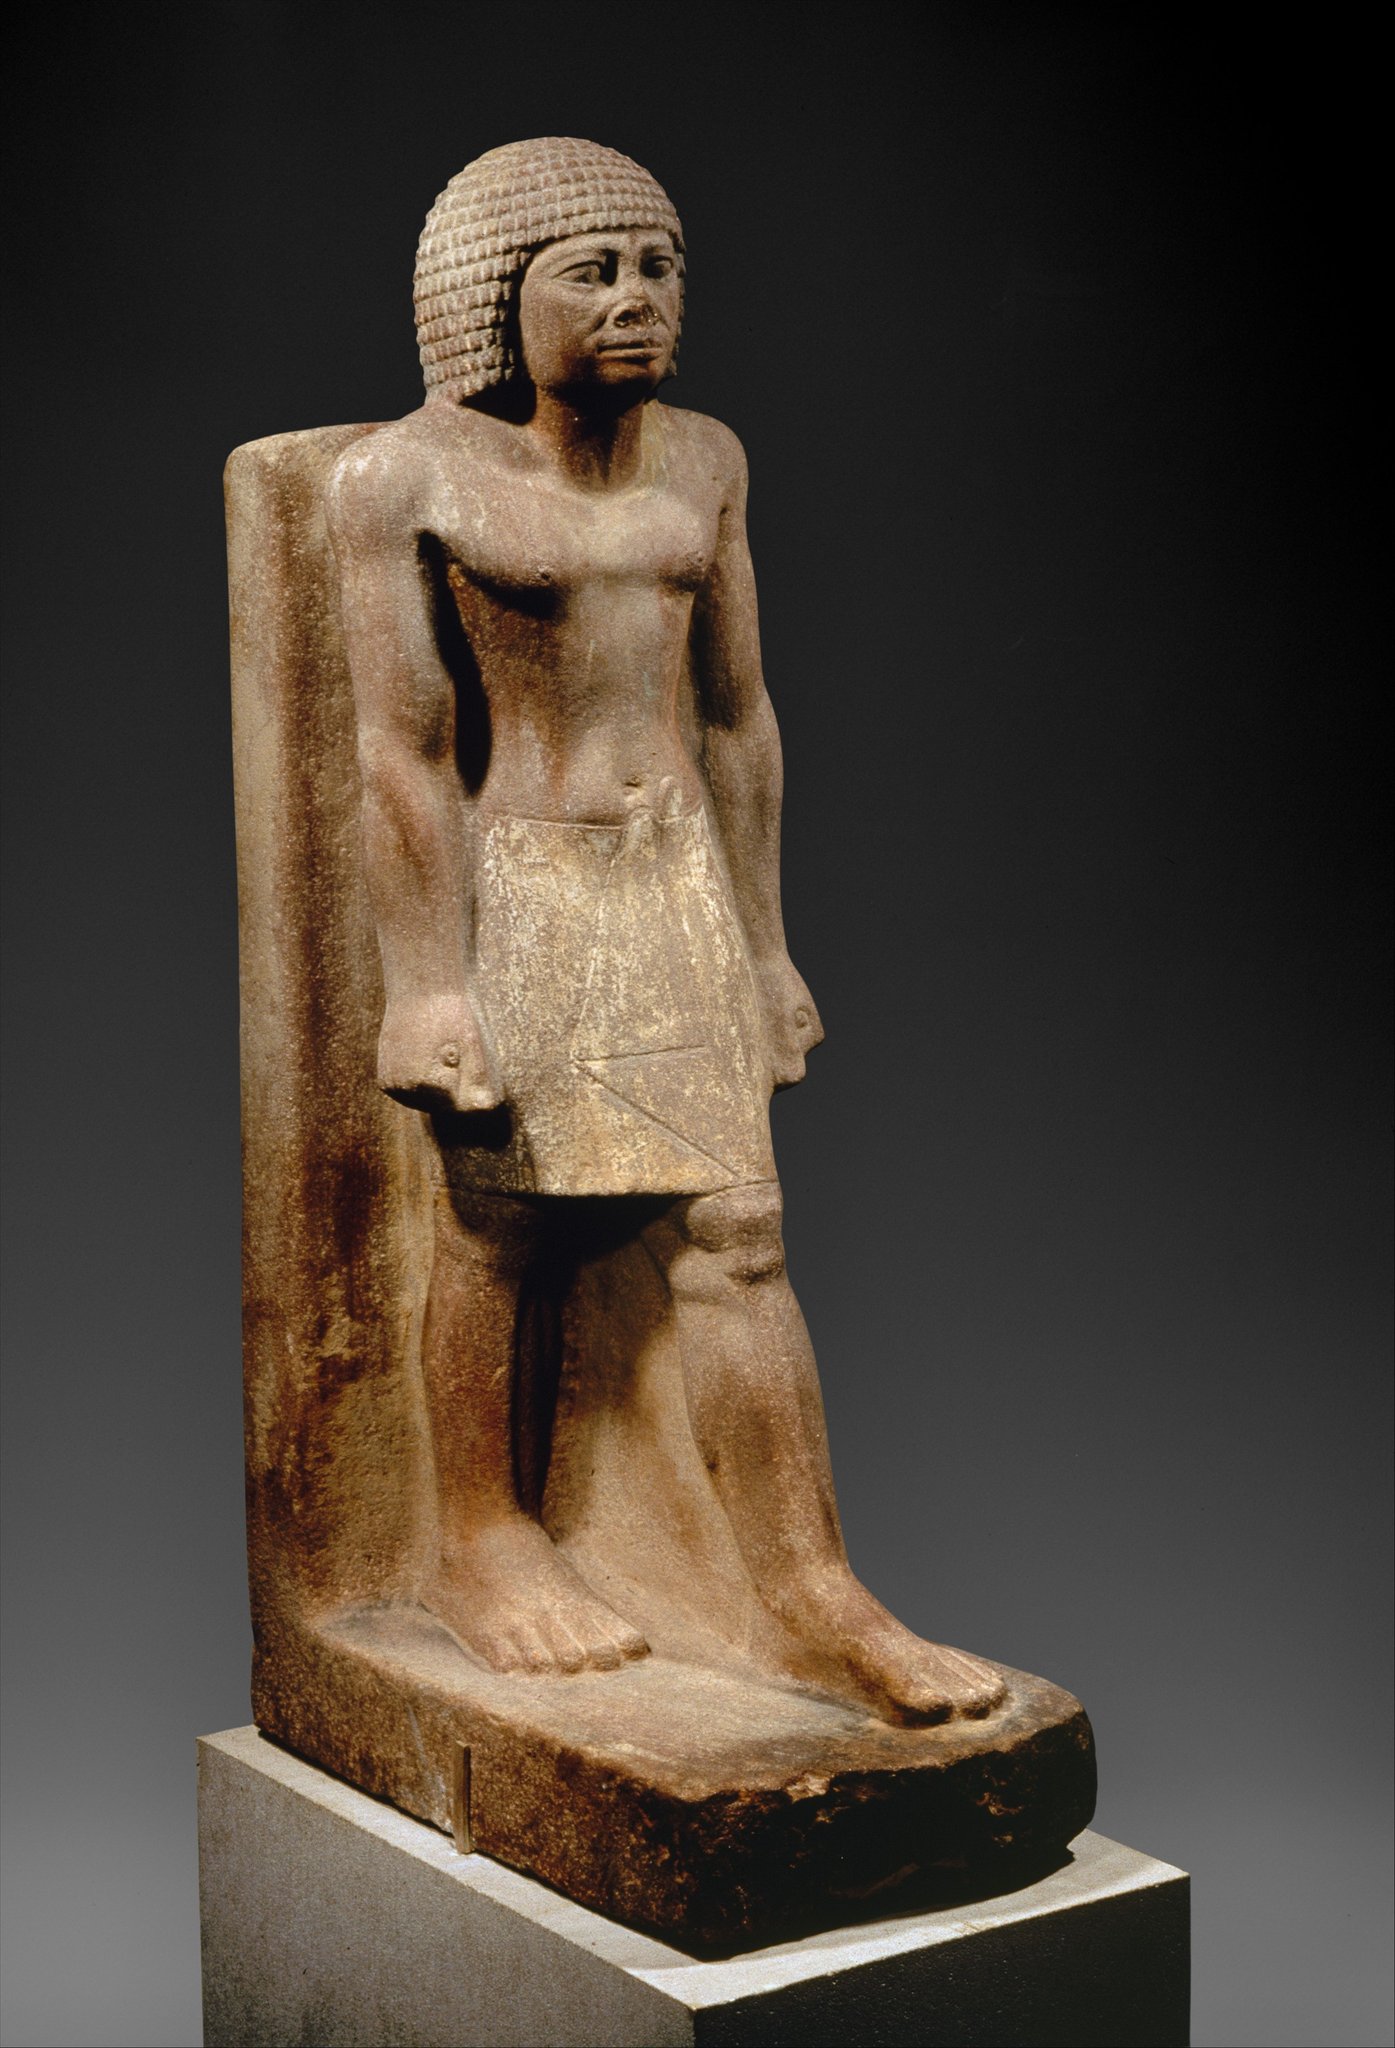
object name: statuette, striding man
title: Striding Figure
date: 2575-2465 BCE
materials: paint, quartzite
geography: southern upper egypt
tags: men